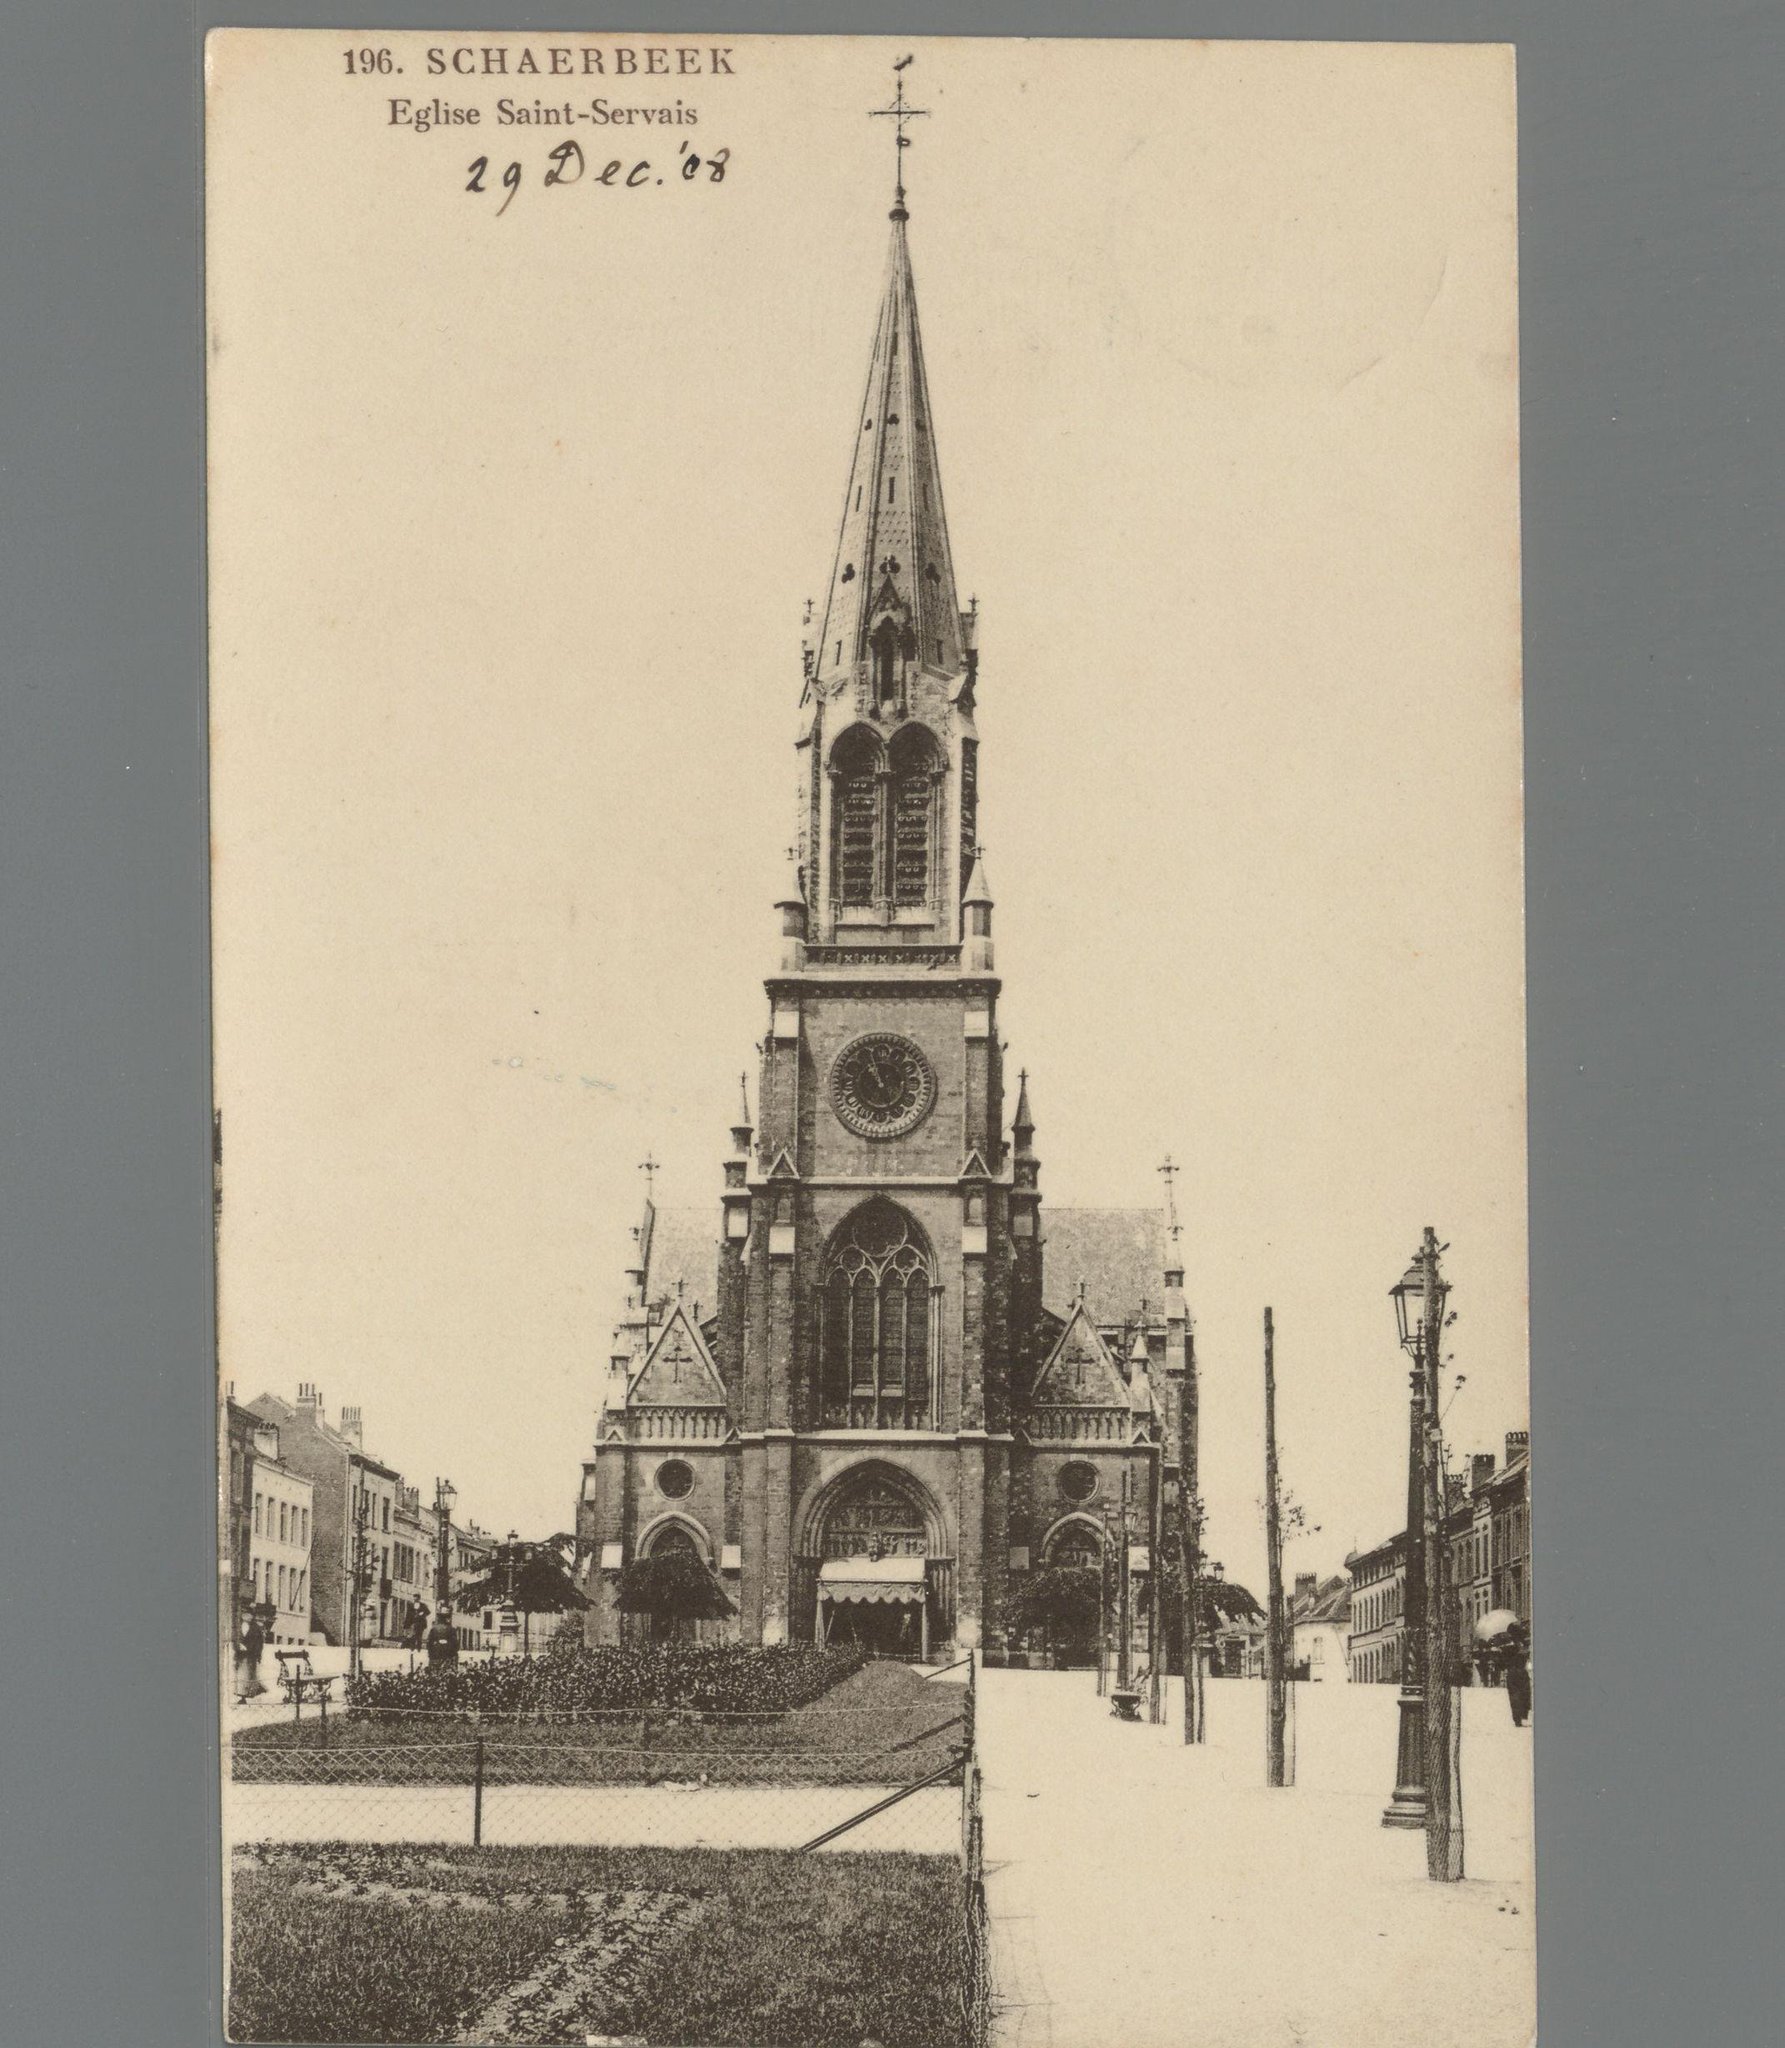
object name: ansichtkaart, prentbriefkaart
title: Schaerbeek. Eglise Saint-Servais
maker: Anonymous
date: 1906-1908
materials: cardboard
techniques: photograph, writing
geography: brussels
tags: city-view, and landscape with man-made constructions, roman catholic church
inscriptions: postage stamp